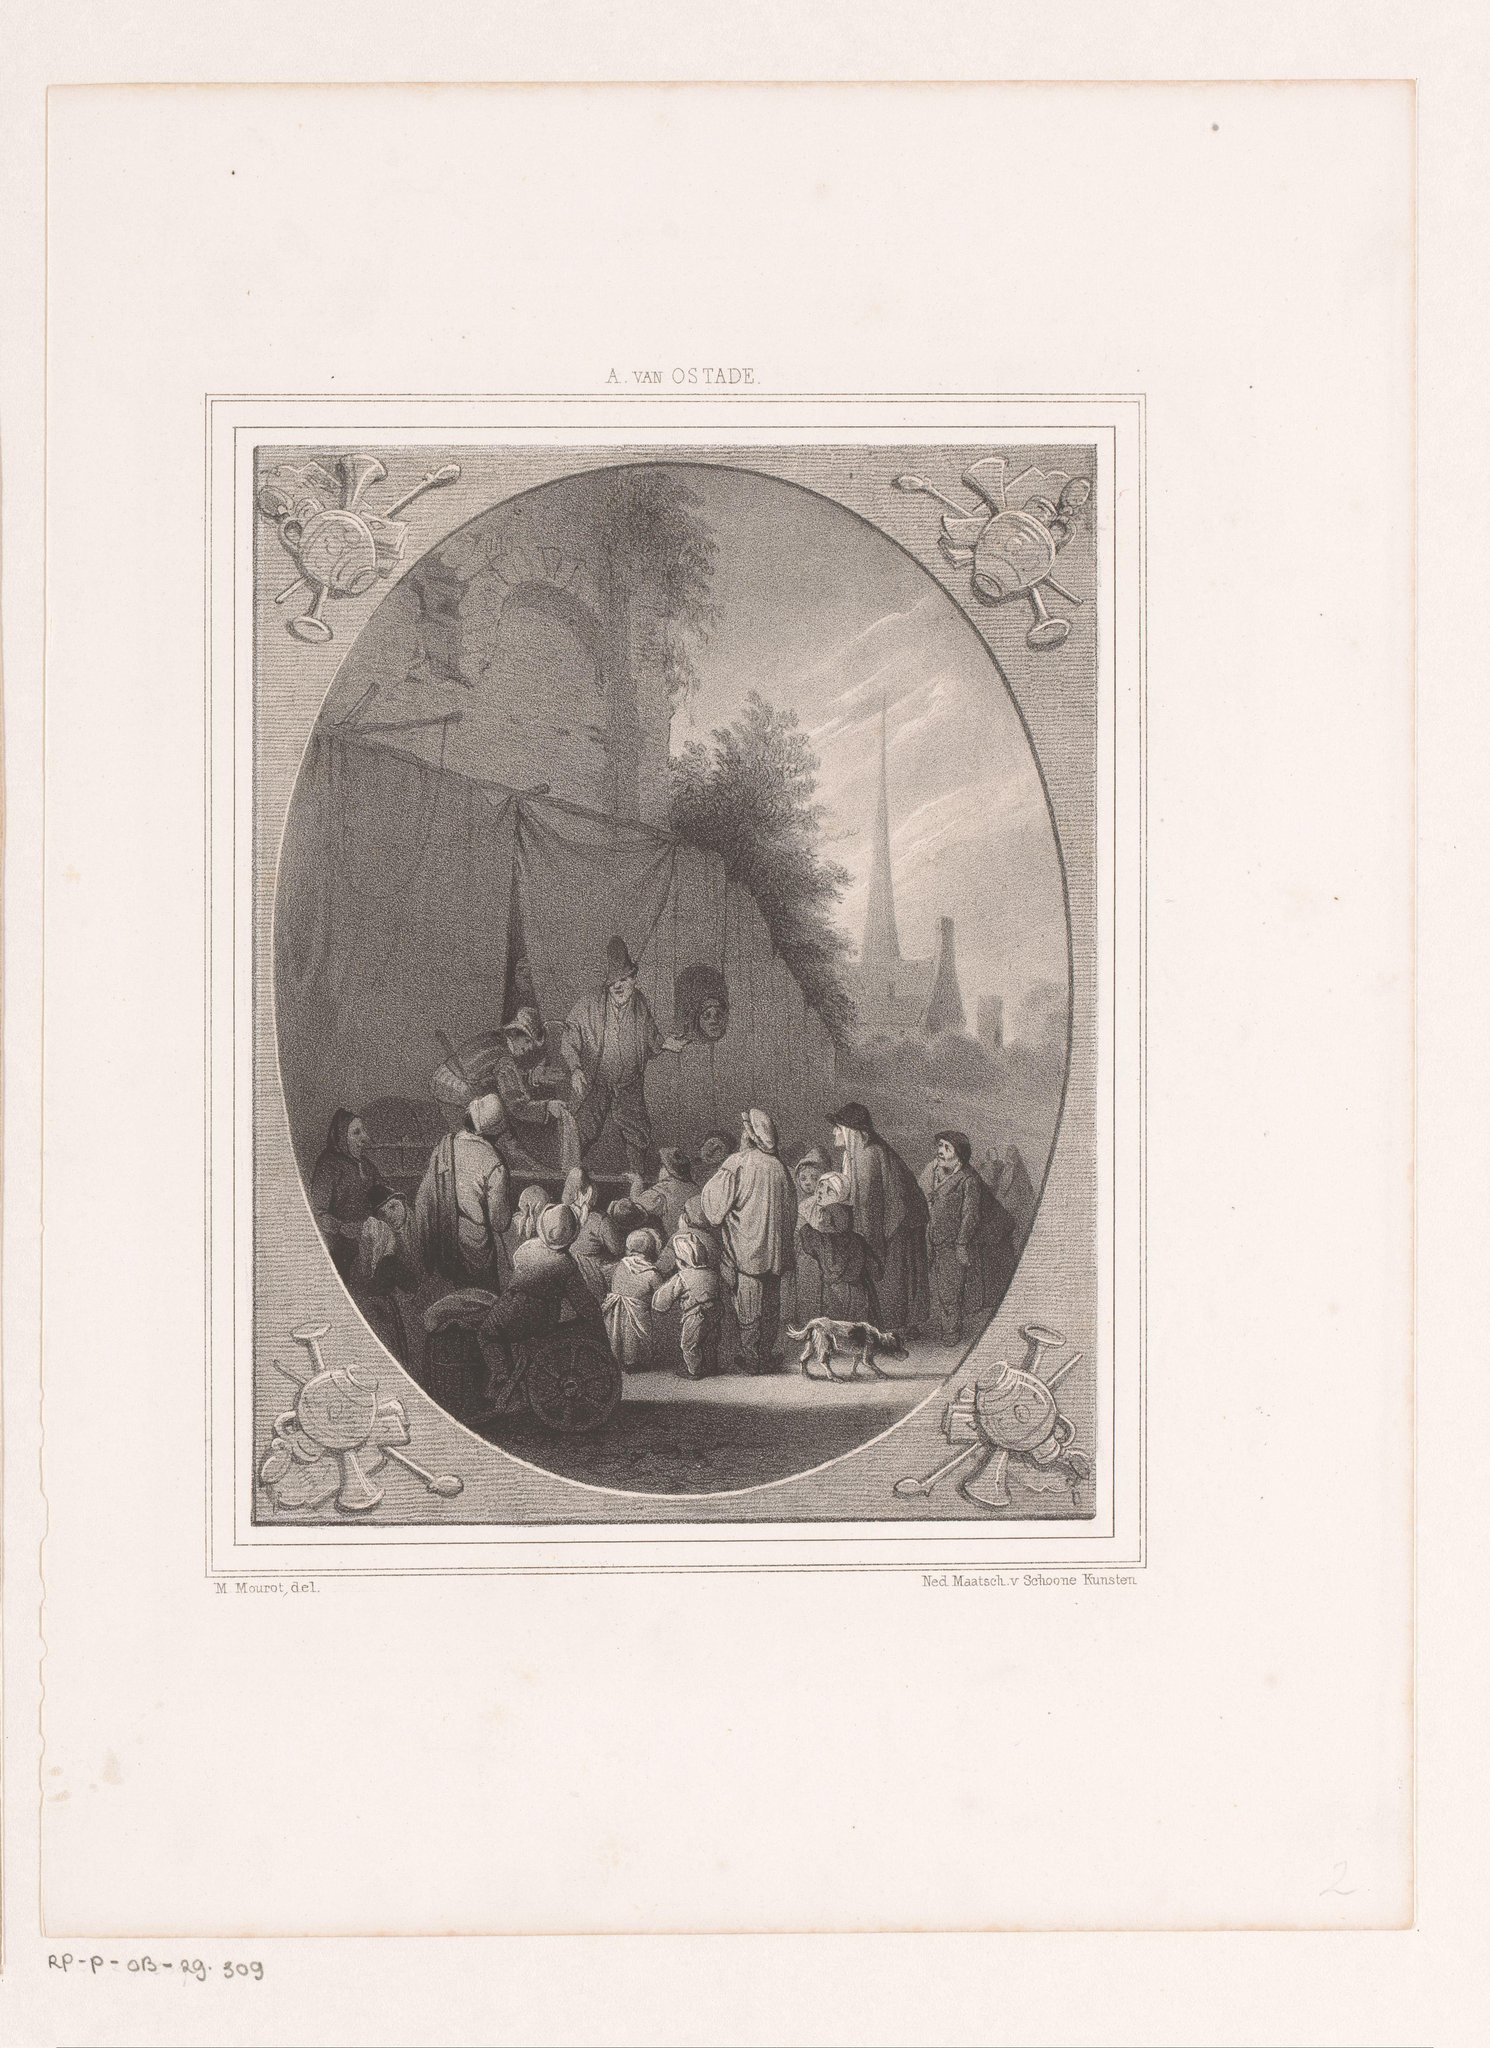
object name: print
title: Toneelopvoering in de buitenlucht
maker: adriaen van ostade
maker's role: draughtsman, painter, print maker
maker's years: 1610-1685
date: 1840-1843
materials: paper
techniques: lithograph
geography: the hague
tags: actor (on the stage), theatre (building) - aa - open-air performances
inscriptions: collector's mark: Lugt 2228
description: Op het podium staan twee mannen. Het publiek kijkt toe. In de achtergrond een kerk. De voorstelling, in een ovaal, is gevat in een lijst. In de hoeken van de lijst objecten waaronder een kruik, een trompet en een geweer.